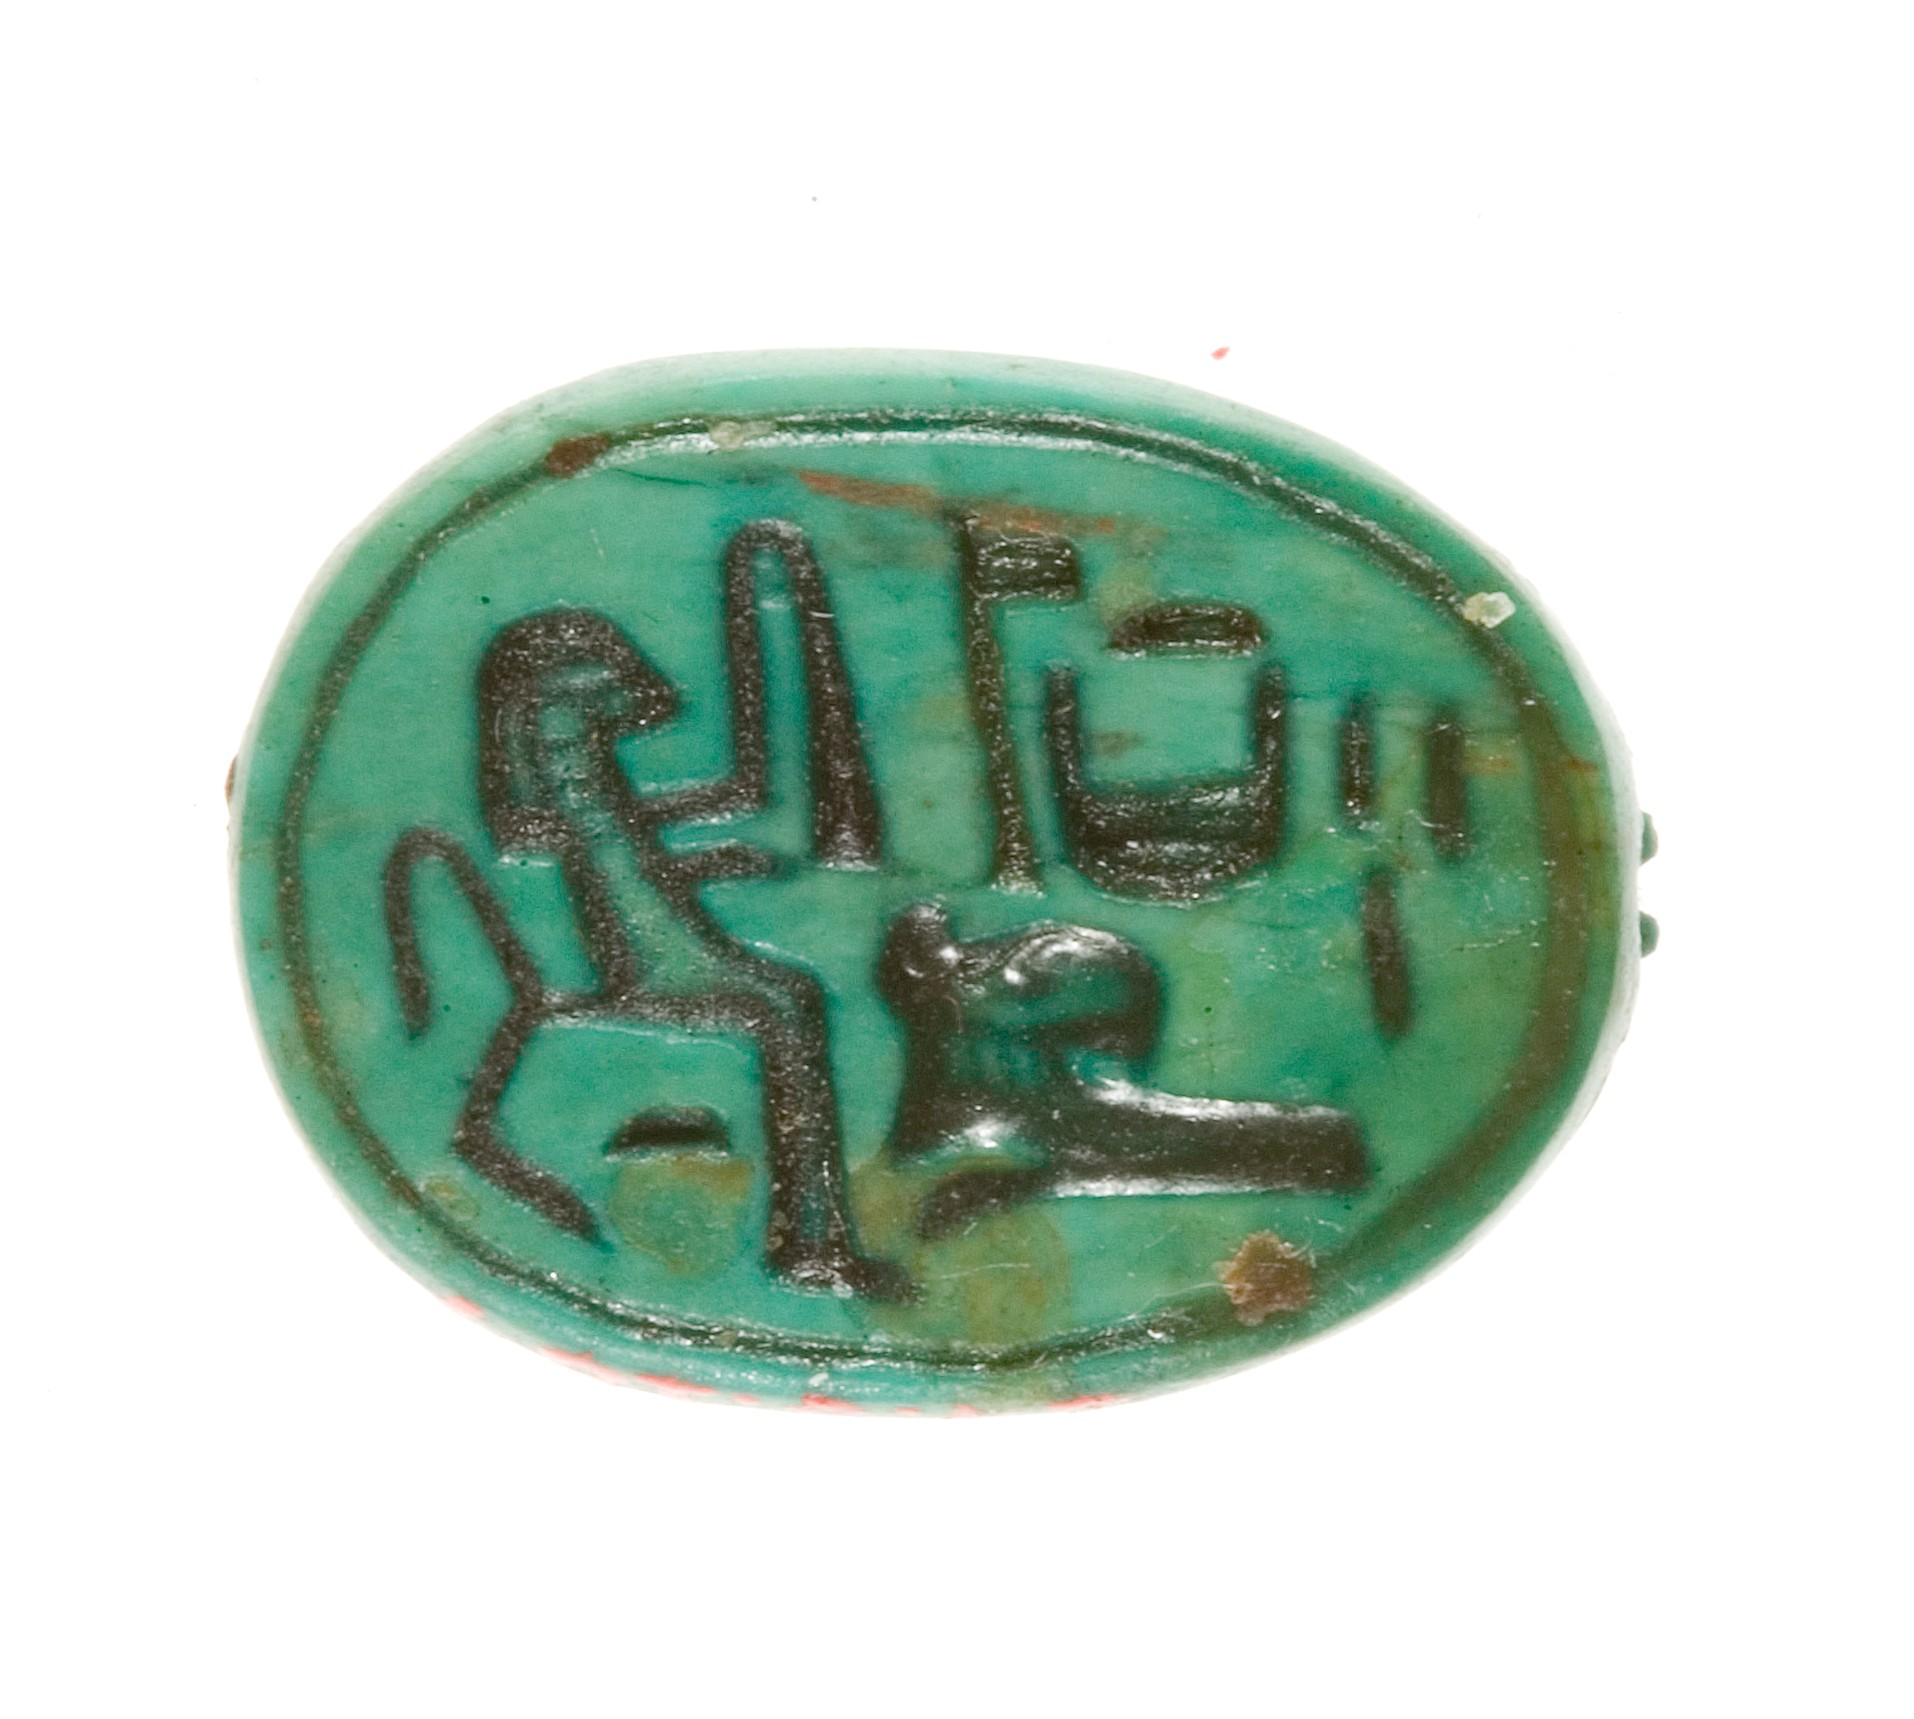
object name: scarab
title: Scarab Inscribed for the God's Wife Hatshepsut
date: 1479-1458 BCE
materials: stone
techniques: glazing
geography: egypt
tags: women,hieroglyphs,scarabs